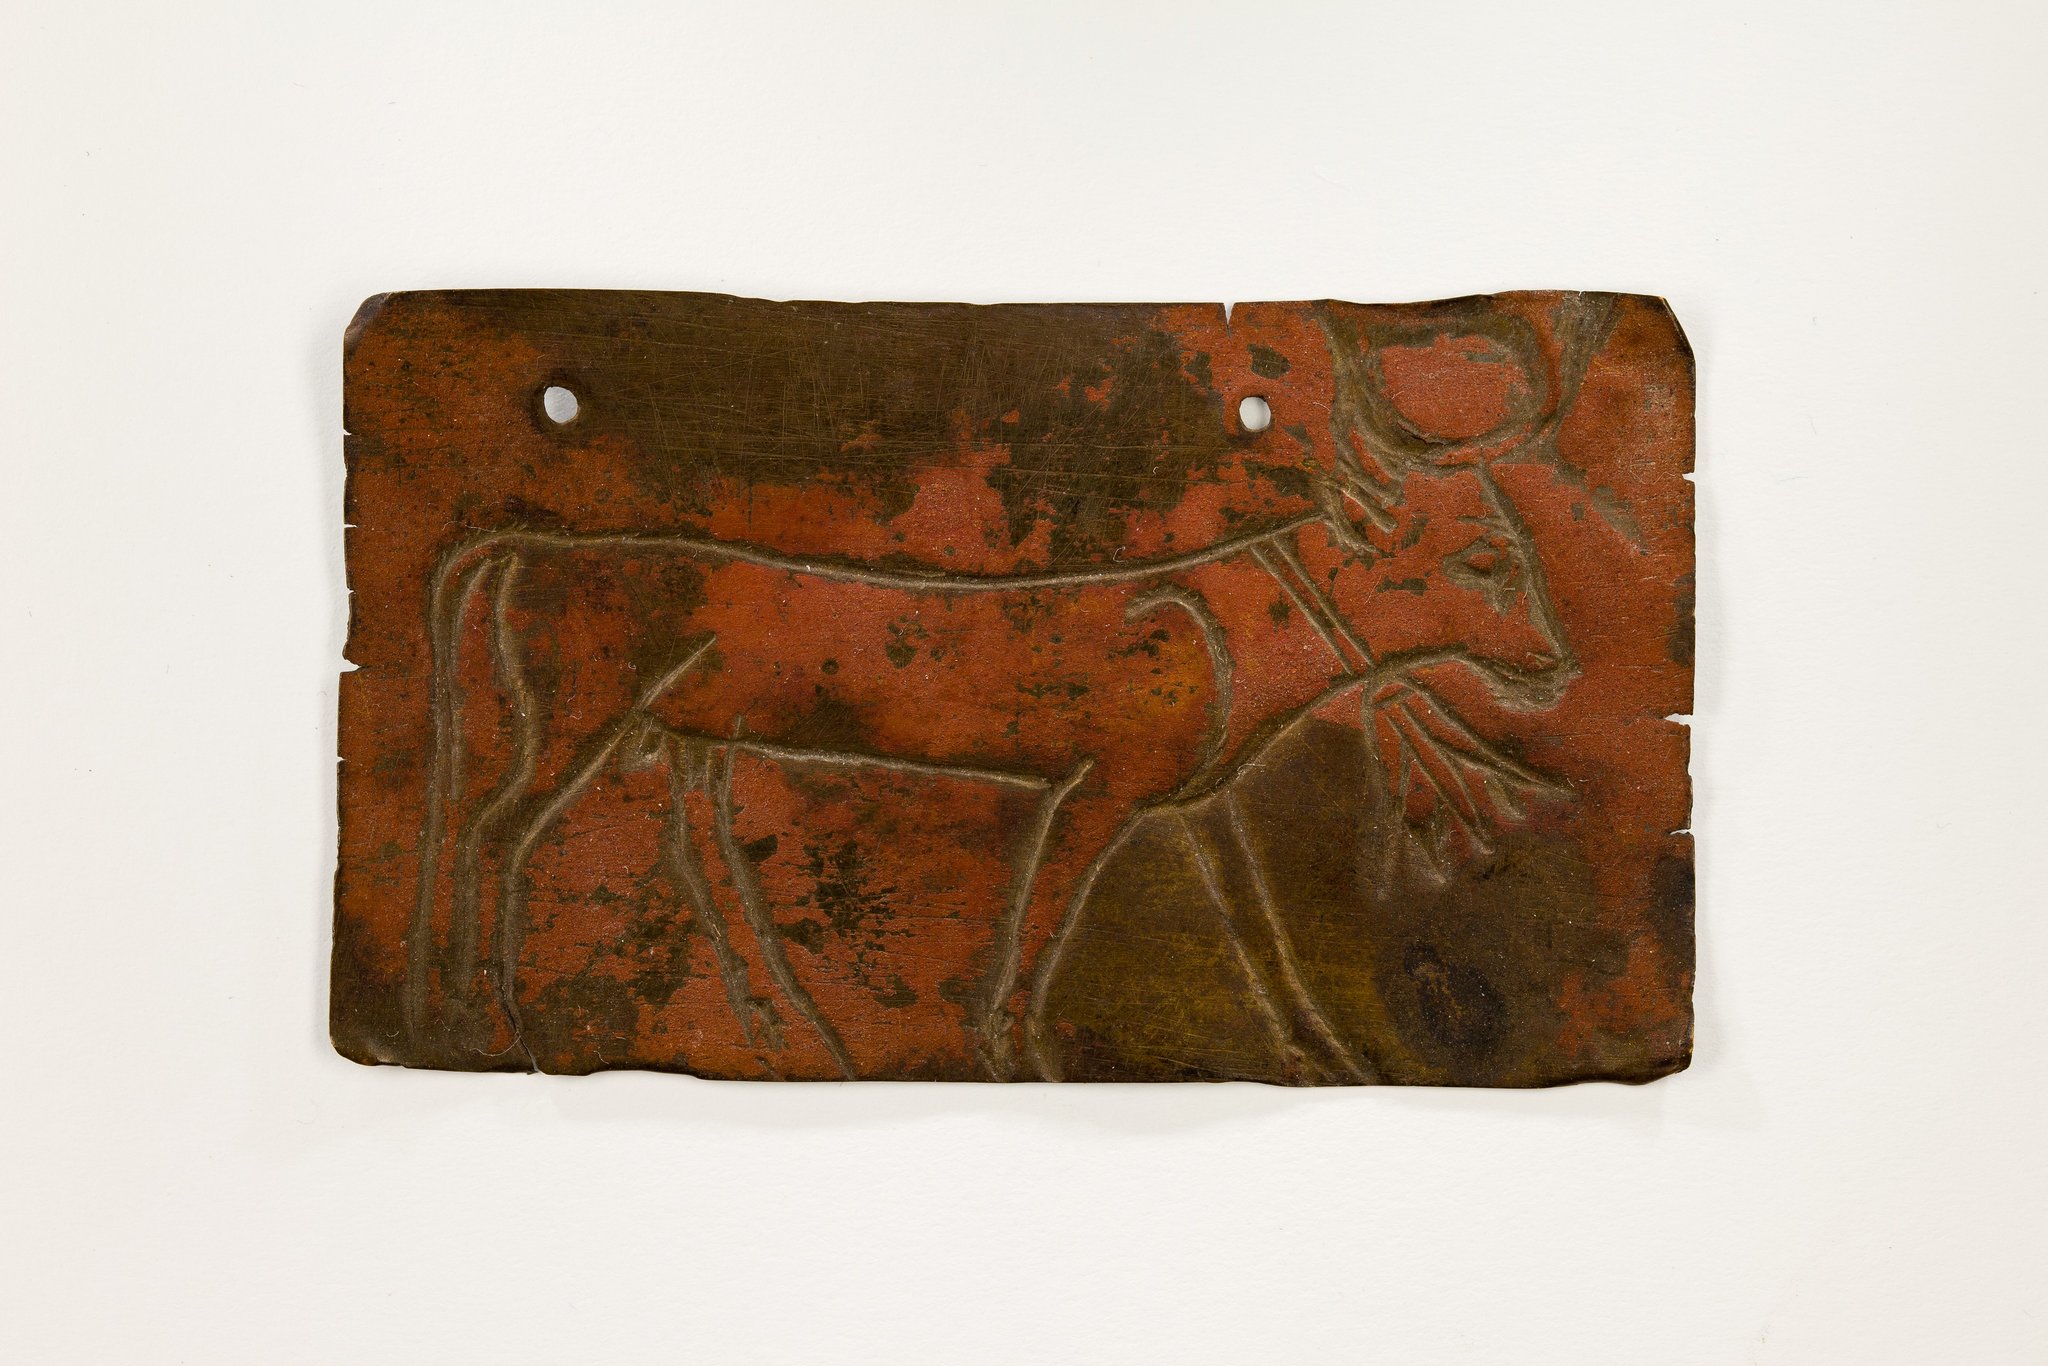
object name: votive, plaque, cow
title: Cow plaque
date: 1479-1458 BCE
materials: bronze, copper alloy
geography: egypt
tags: cows